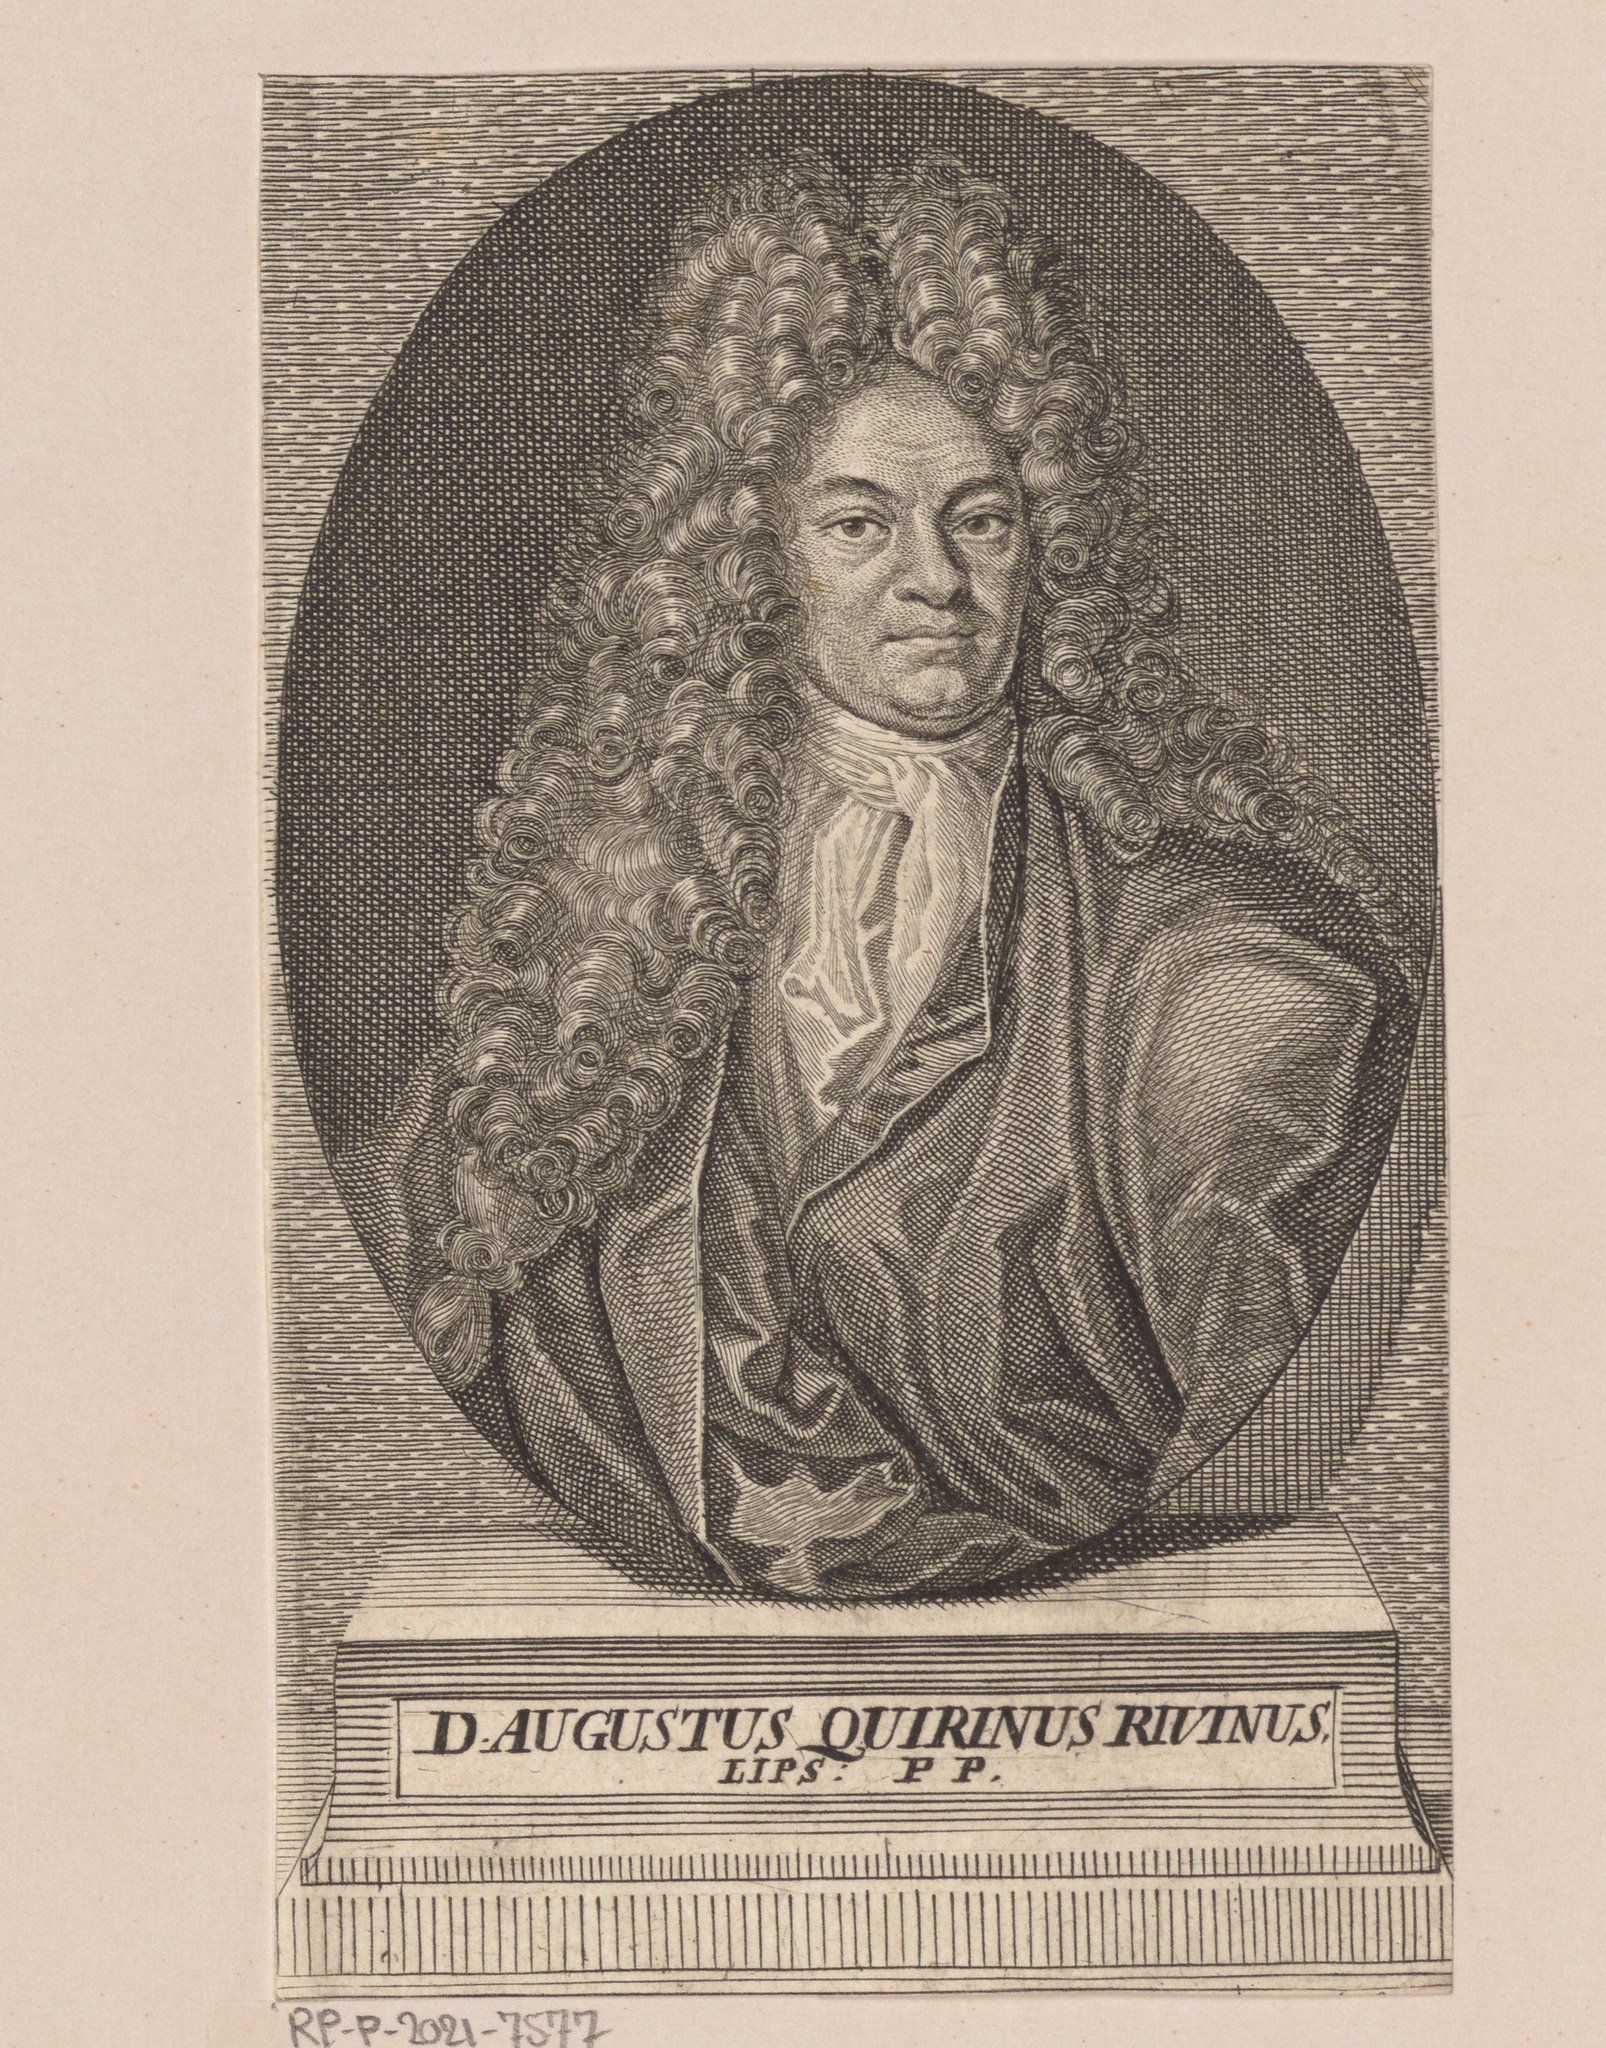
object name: print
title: Portret van August Quirinus Rivinus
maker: johann georg mentzel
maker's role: print maker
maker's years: 1677-1743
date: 1687-1743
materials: paper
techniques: engraving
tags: historical persons